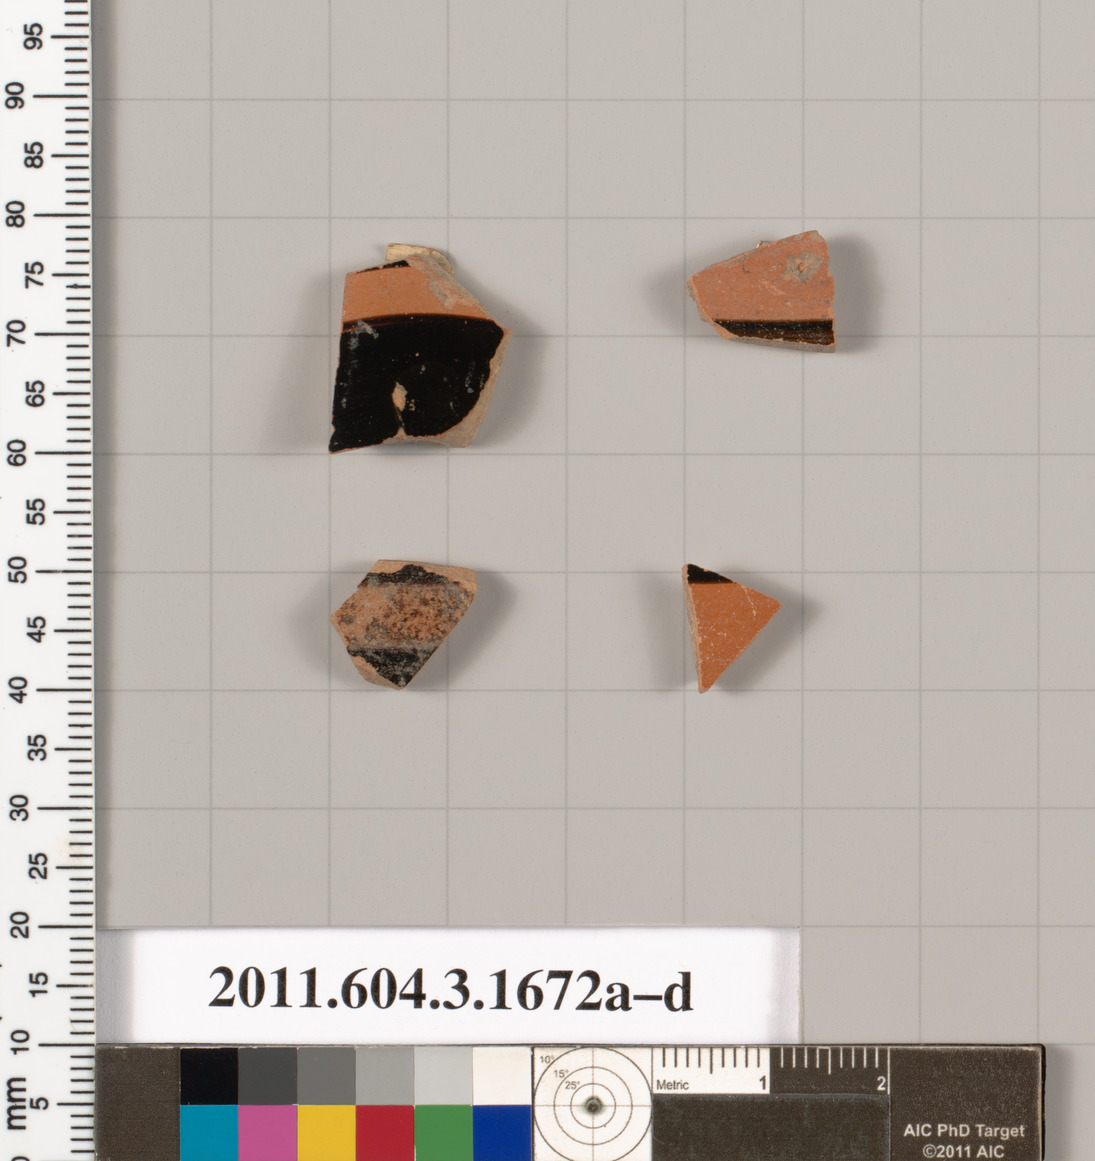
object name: kylix fragment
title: Terracotta fragments of kylikes: Band or lip cups (drinking cups)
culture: greek, attic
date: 550-526 BCE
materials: terracotta